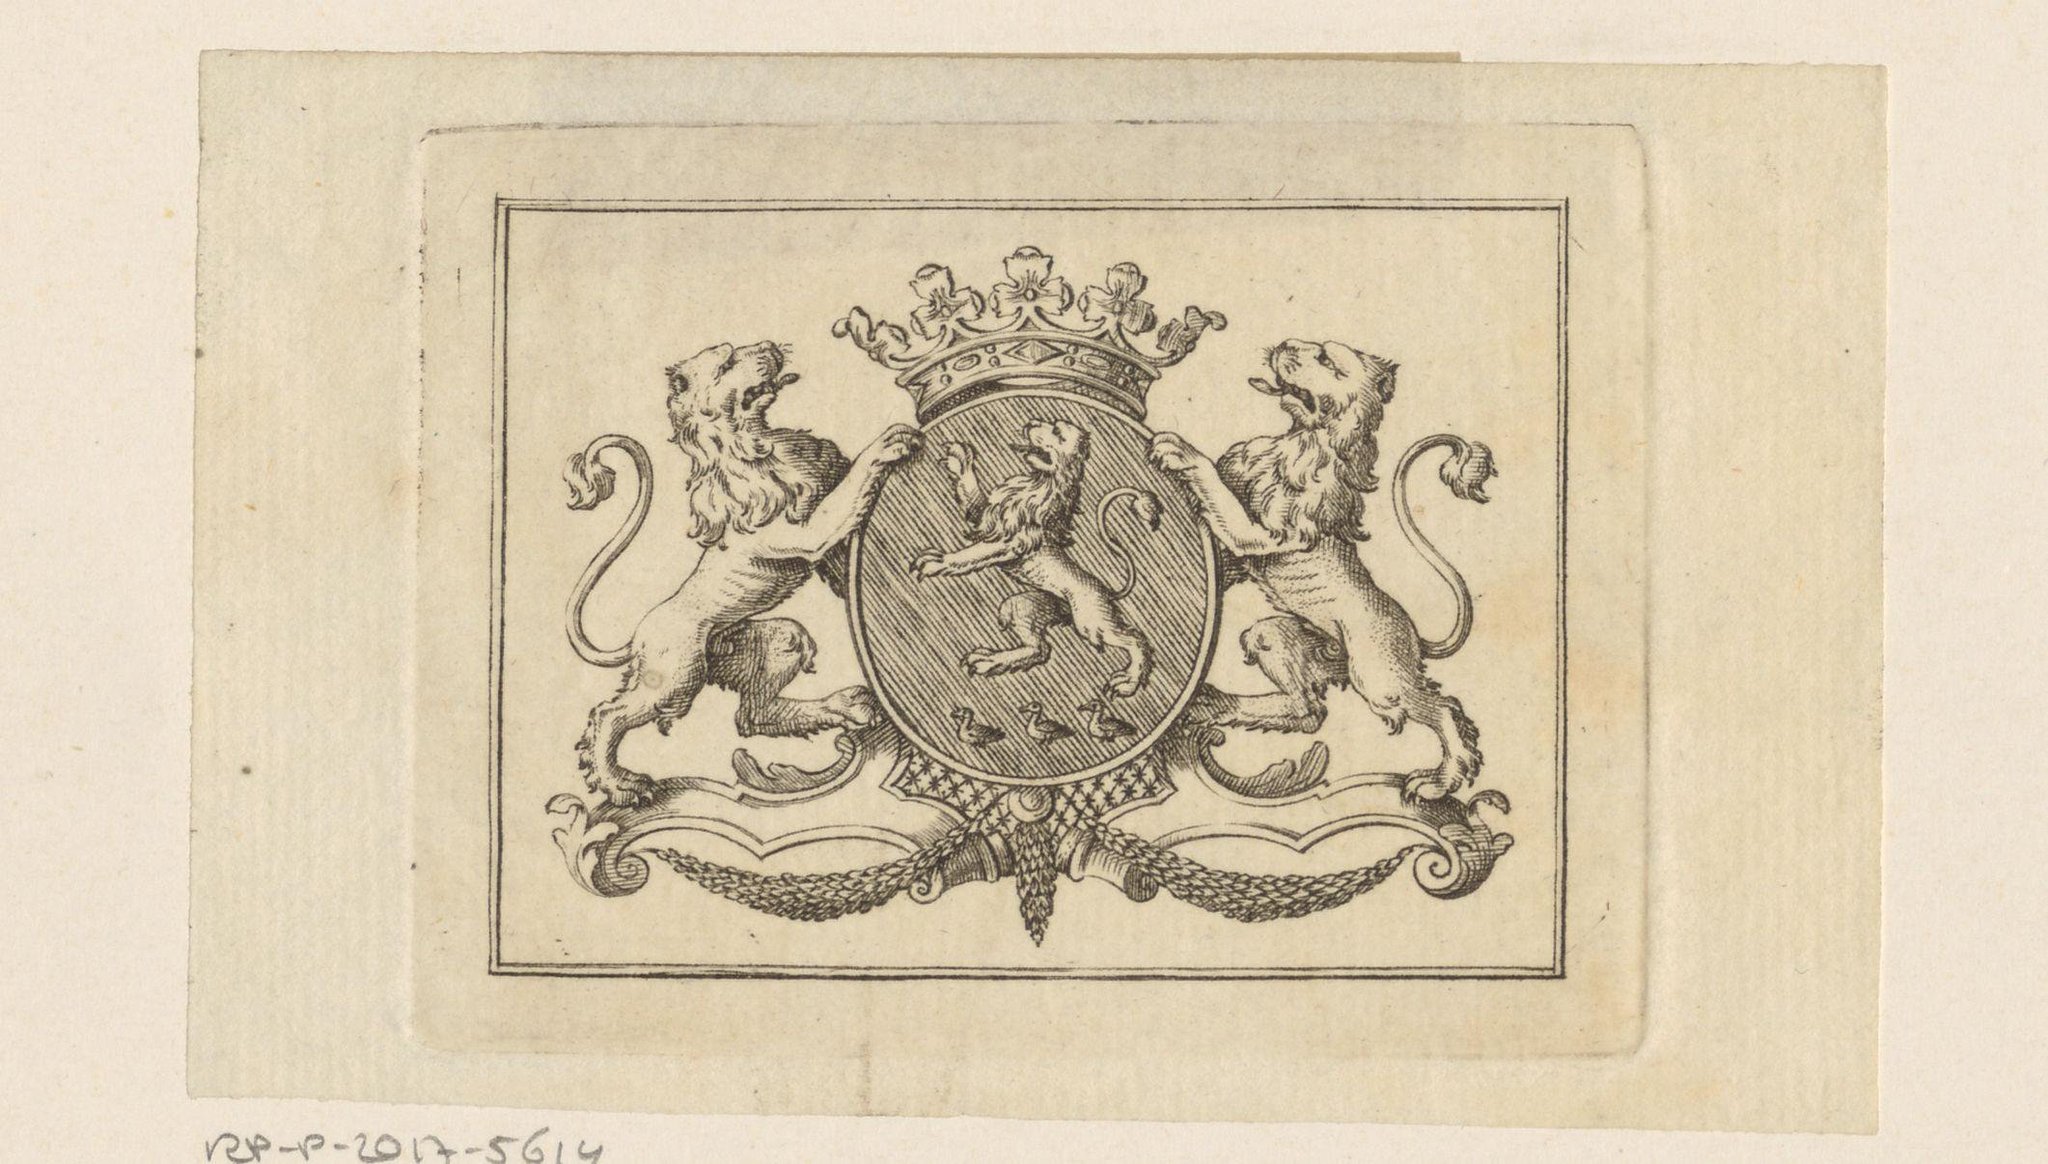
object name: bookplate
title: Ex libris van onbekend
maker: Anonymous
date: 1750-1849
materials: paper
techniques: etching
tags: beasts of prey, predatory animals: lion, armorial bearing, heraldry